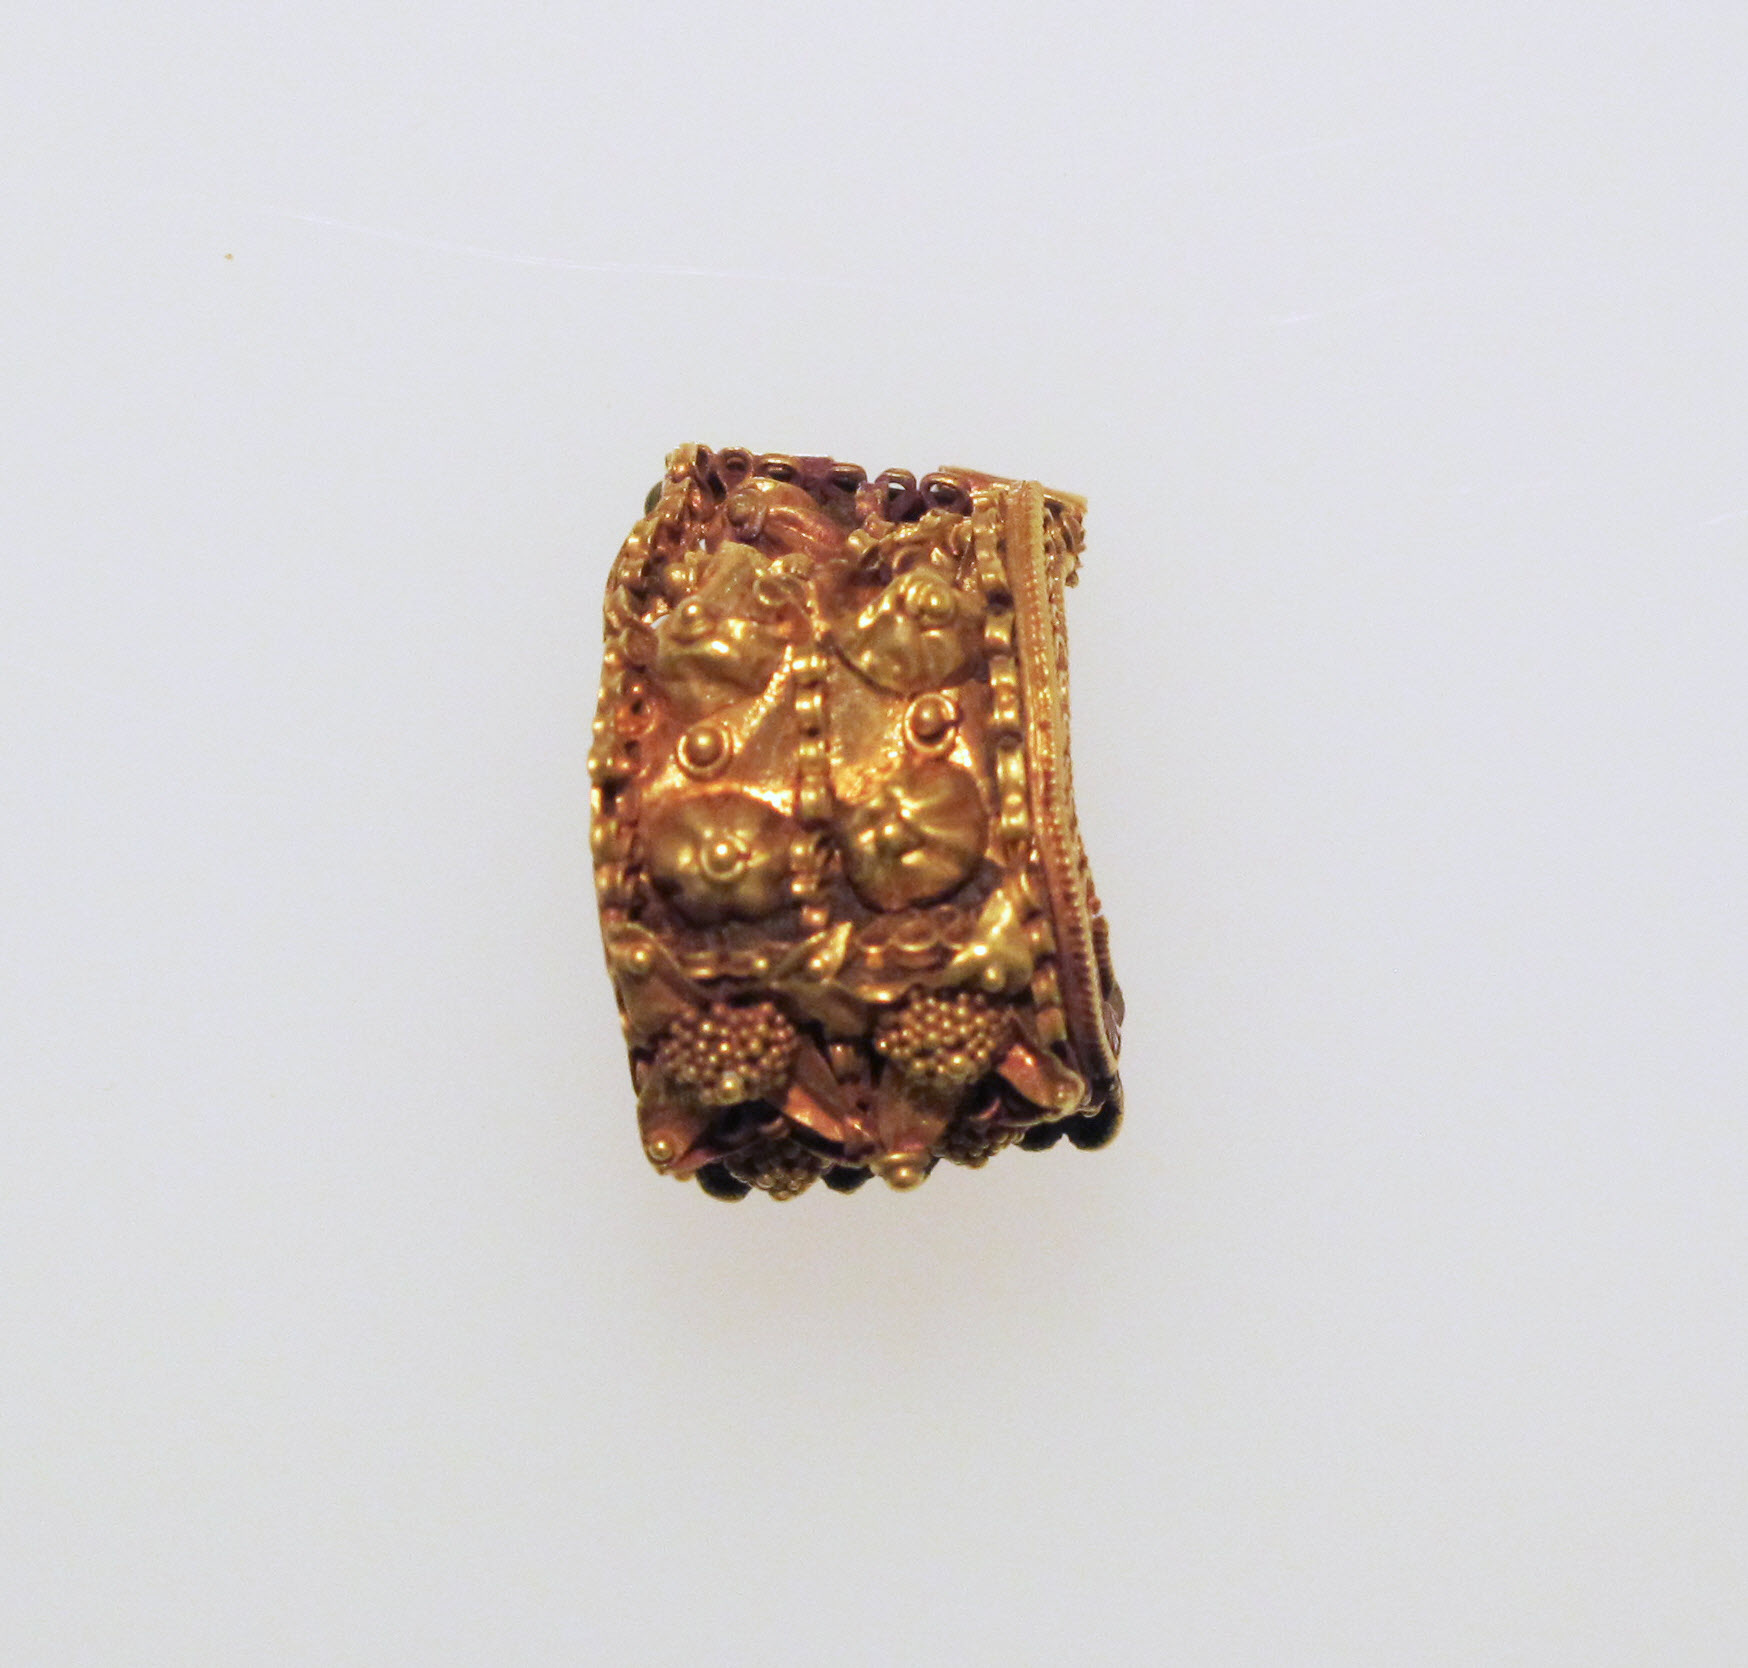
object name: earring, baule type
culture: etruscan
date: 700-401 BCE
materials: gold